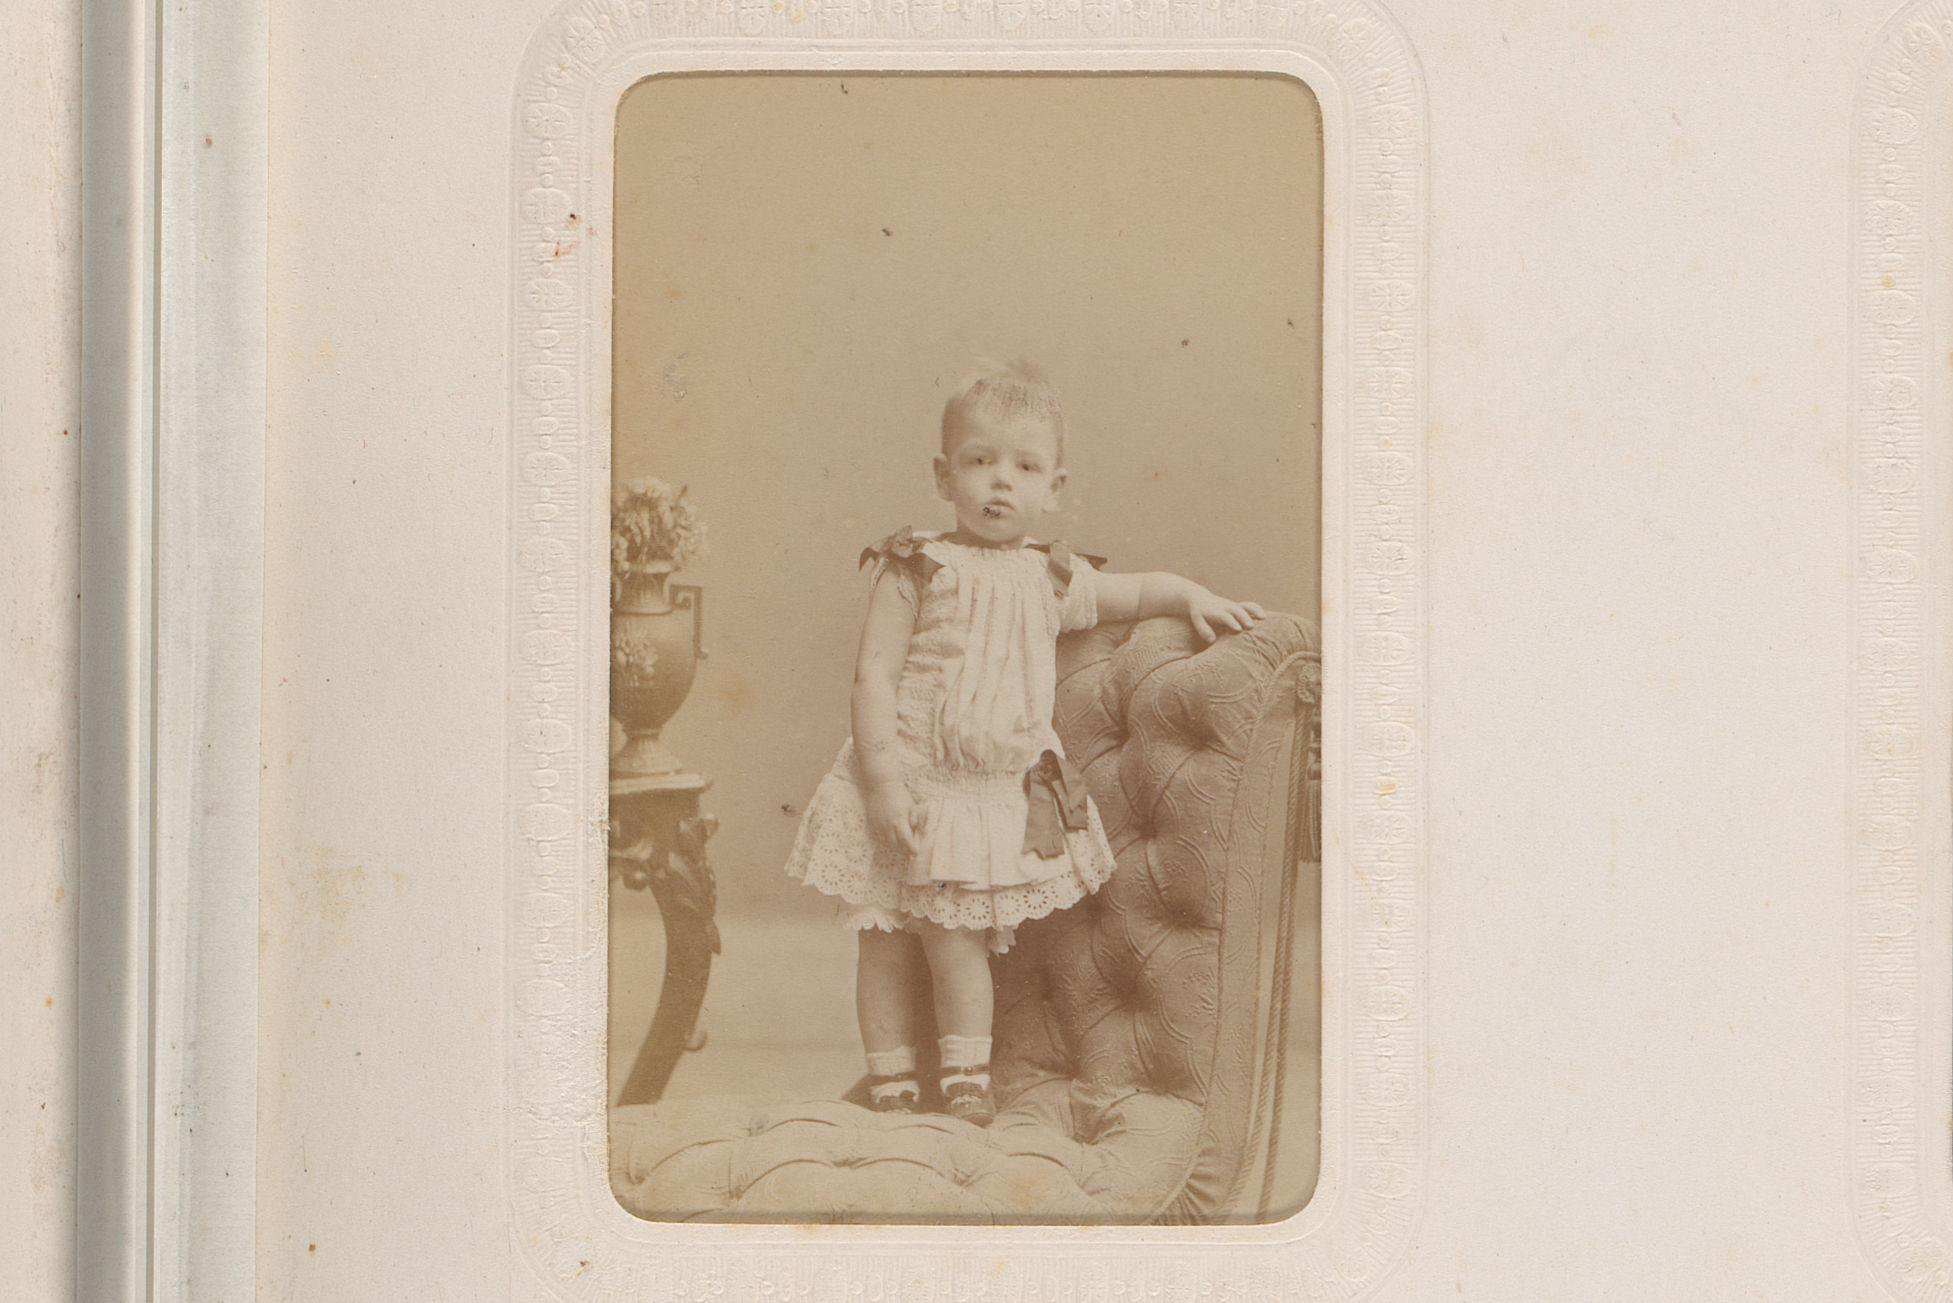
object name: album leaf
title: Portret van drie kinderen bij een hek van takken, met een fiets en een stuk speelgoed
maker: Anonymous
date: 1860-1900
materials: cardboard, photographic support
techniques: albumen print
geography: netherlands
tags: boy (child between toddler and youth), fence, wall, paling, girl (child between toddler and youth) (+ two persons), bicycle, anonymous historical persons portrayed in a group, in a group-portrait